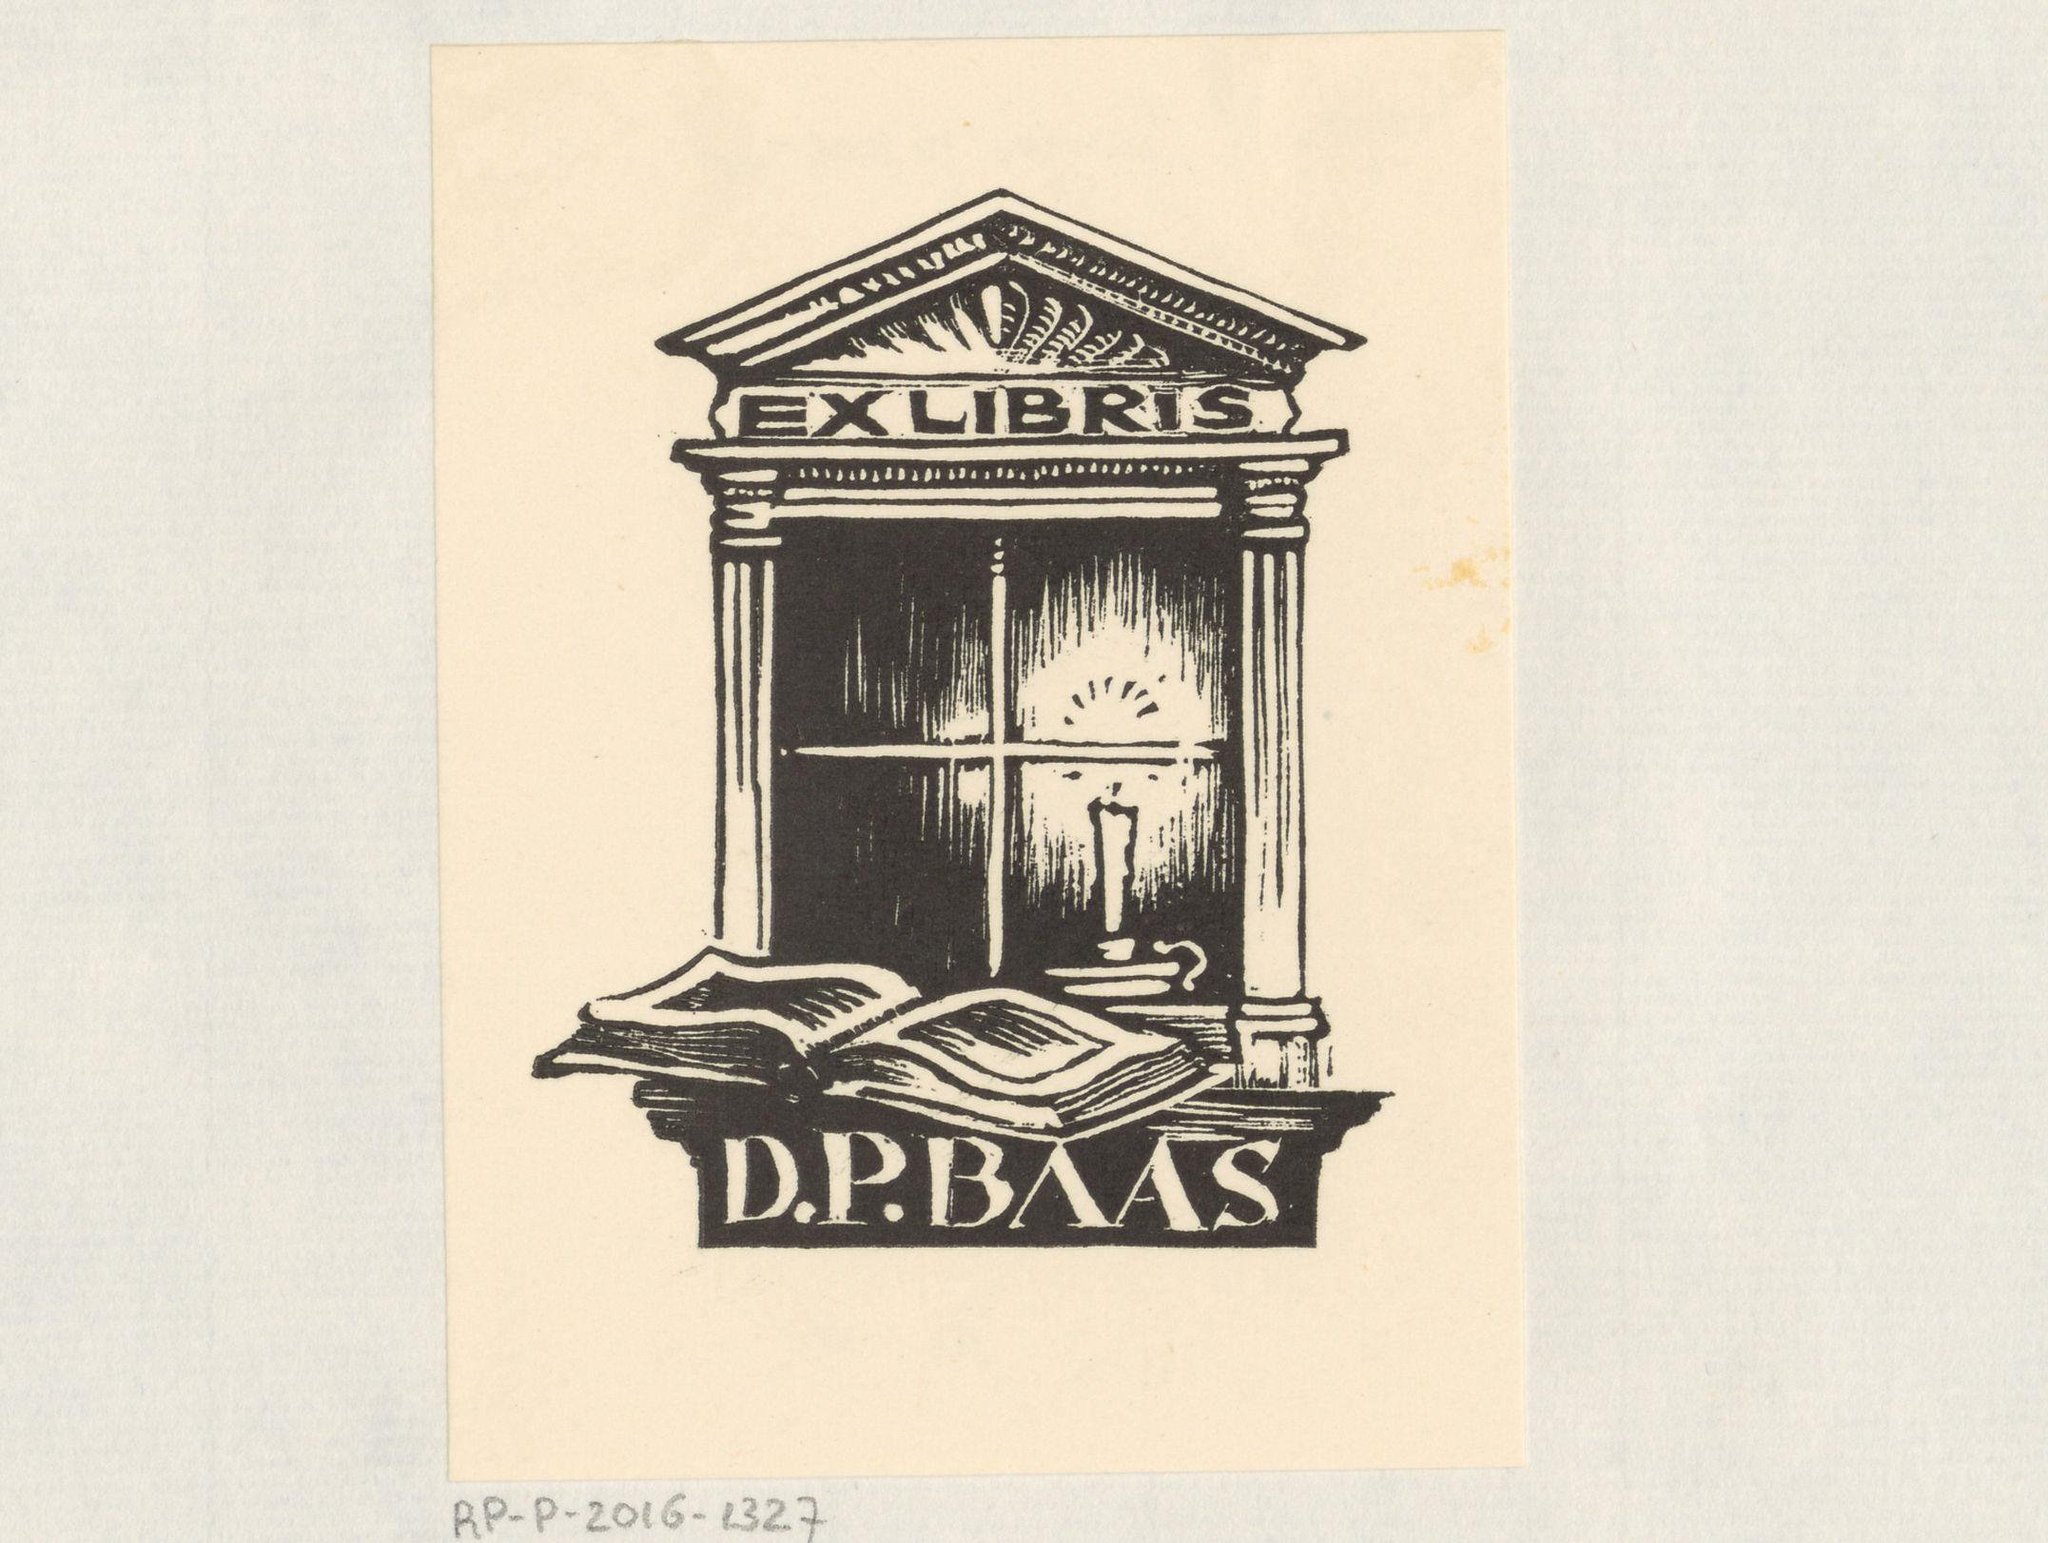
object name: bookplate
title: Ex libris van Dirk Pieter Baas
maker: Anonymous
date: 1930-1970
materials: paper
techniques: woodcut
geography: netherlands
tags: candle